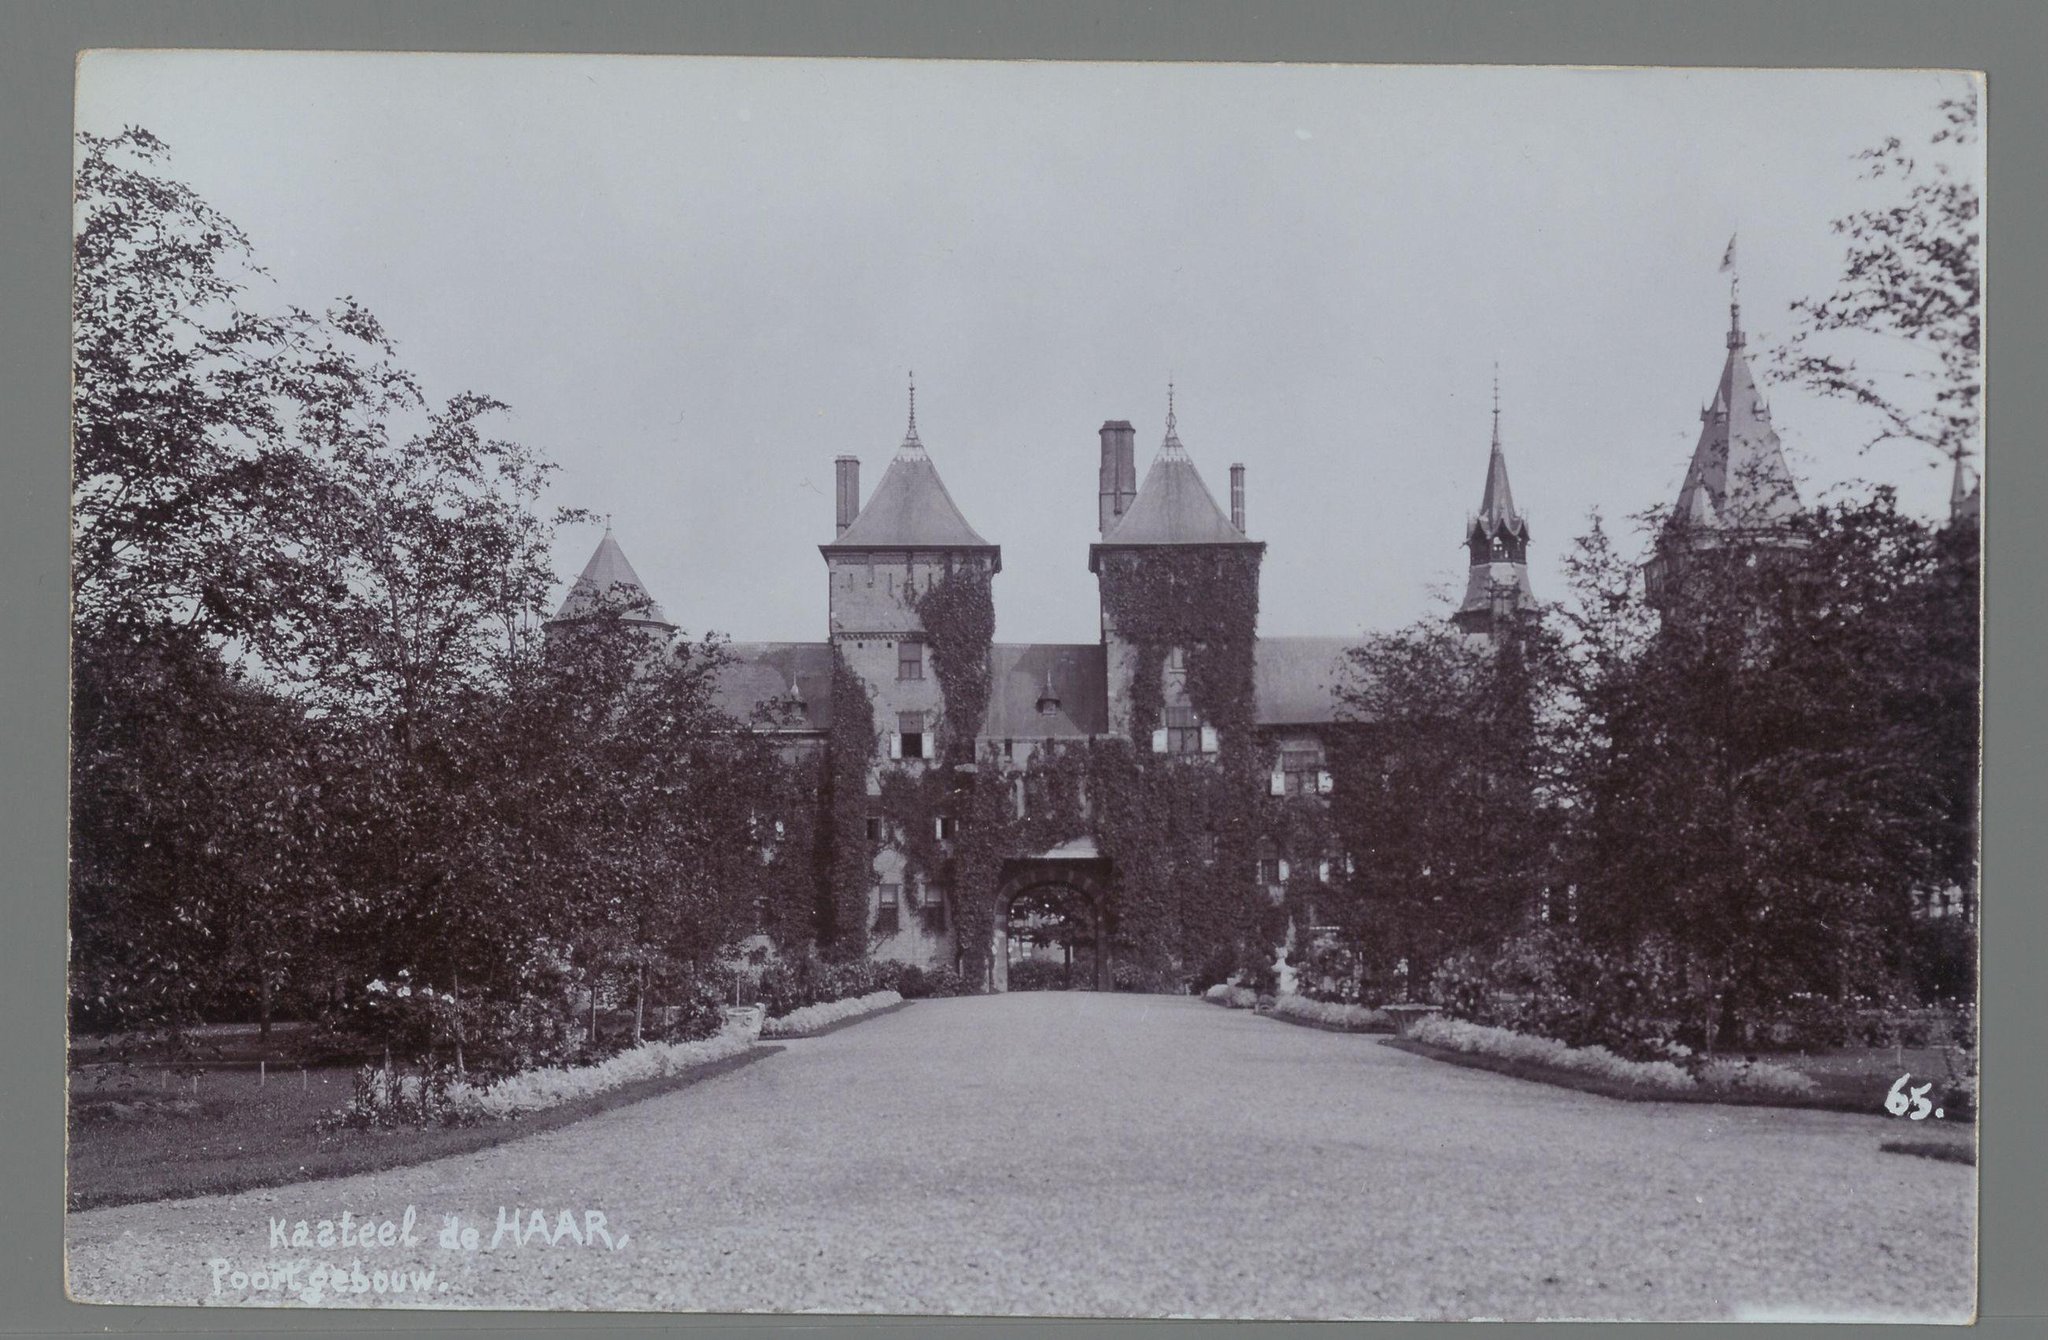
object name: ansichtkaart, prentbriefkaart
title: Kasteel de Haar. Poortgebouw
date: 1900-1930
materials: paper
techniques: collodion silver print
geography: haarzuilens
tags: castle, gate, entrance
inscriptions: monogram: ‘M.R.A. U.’